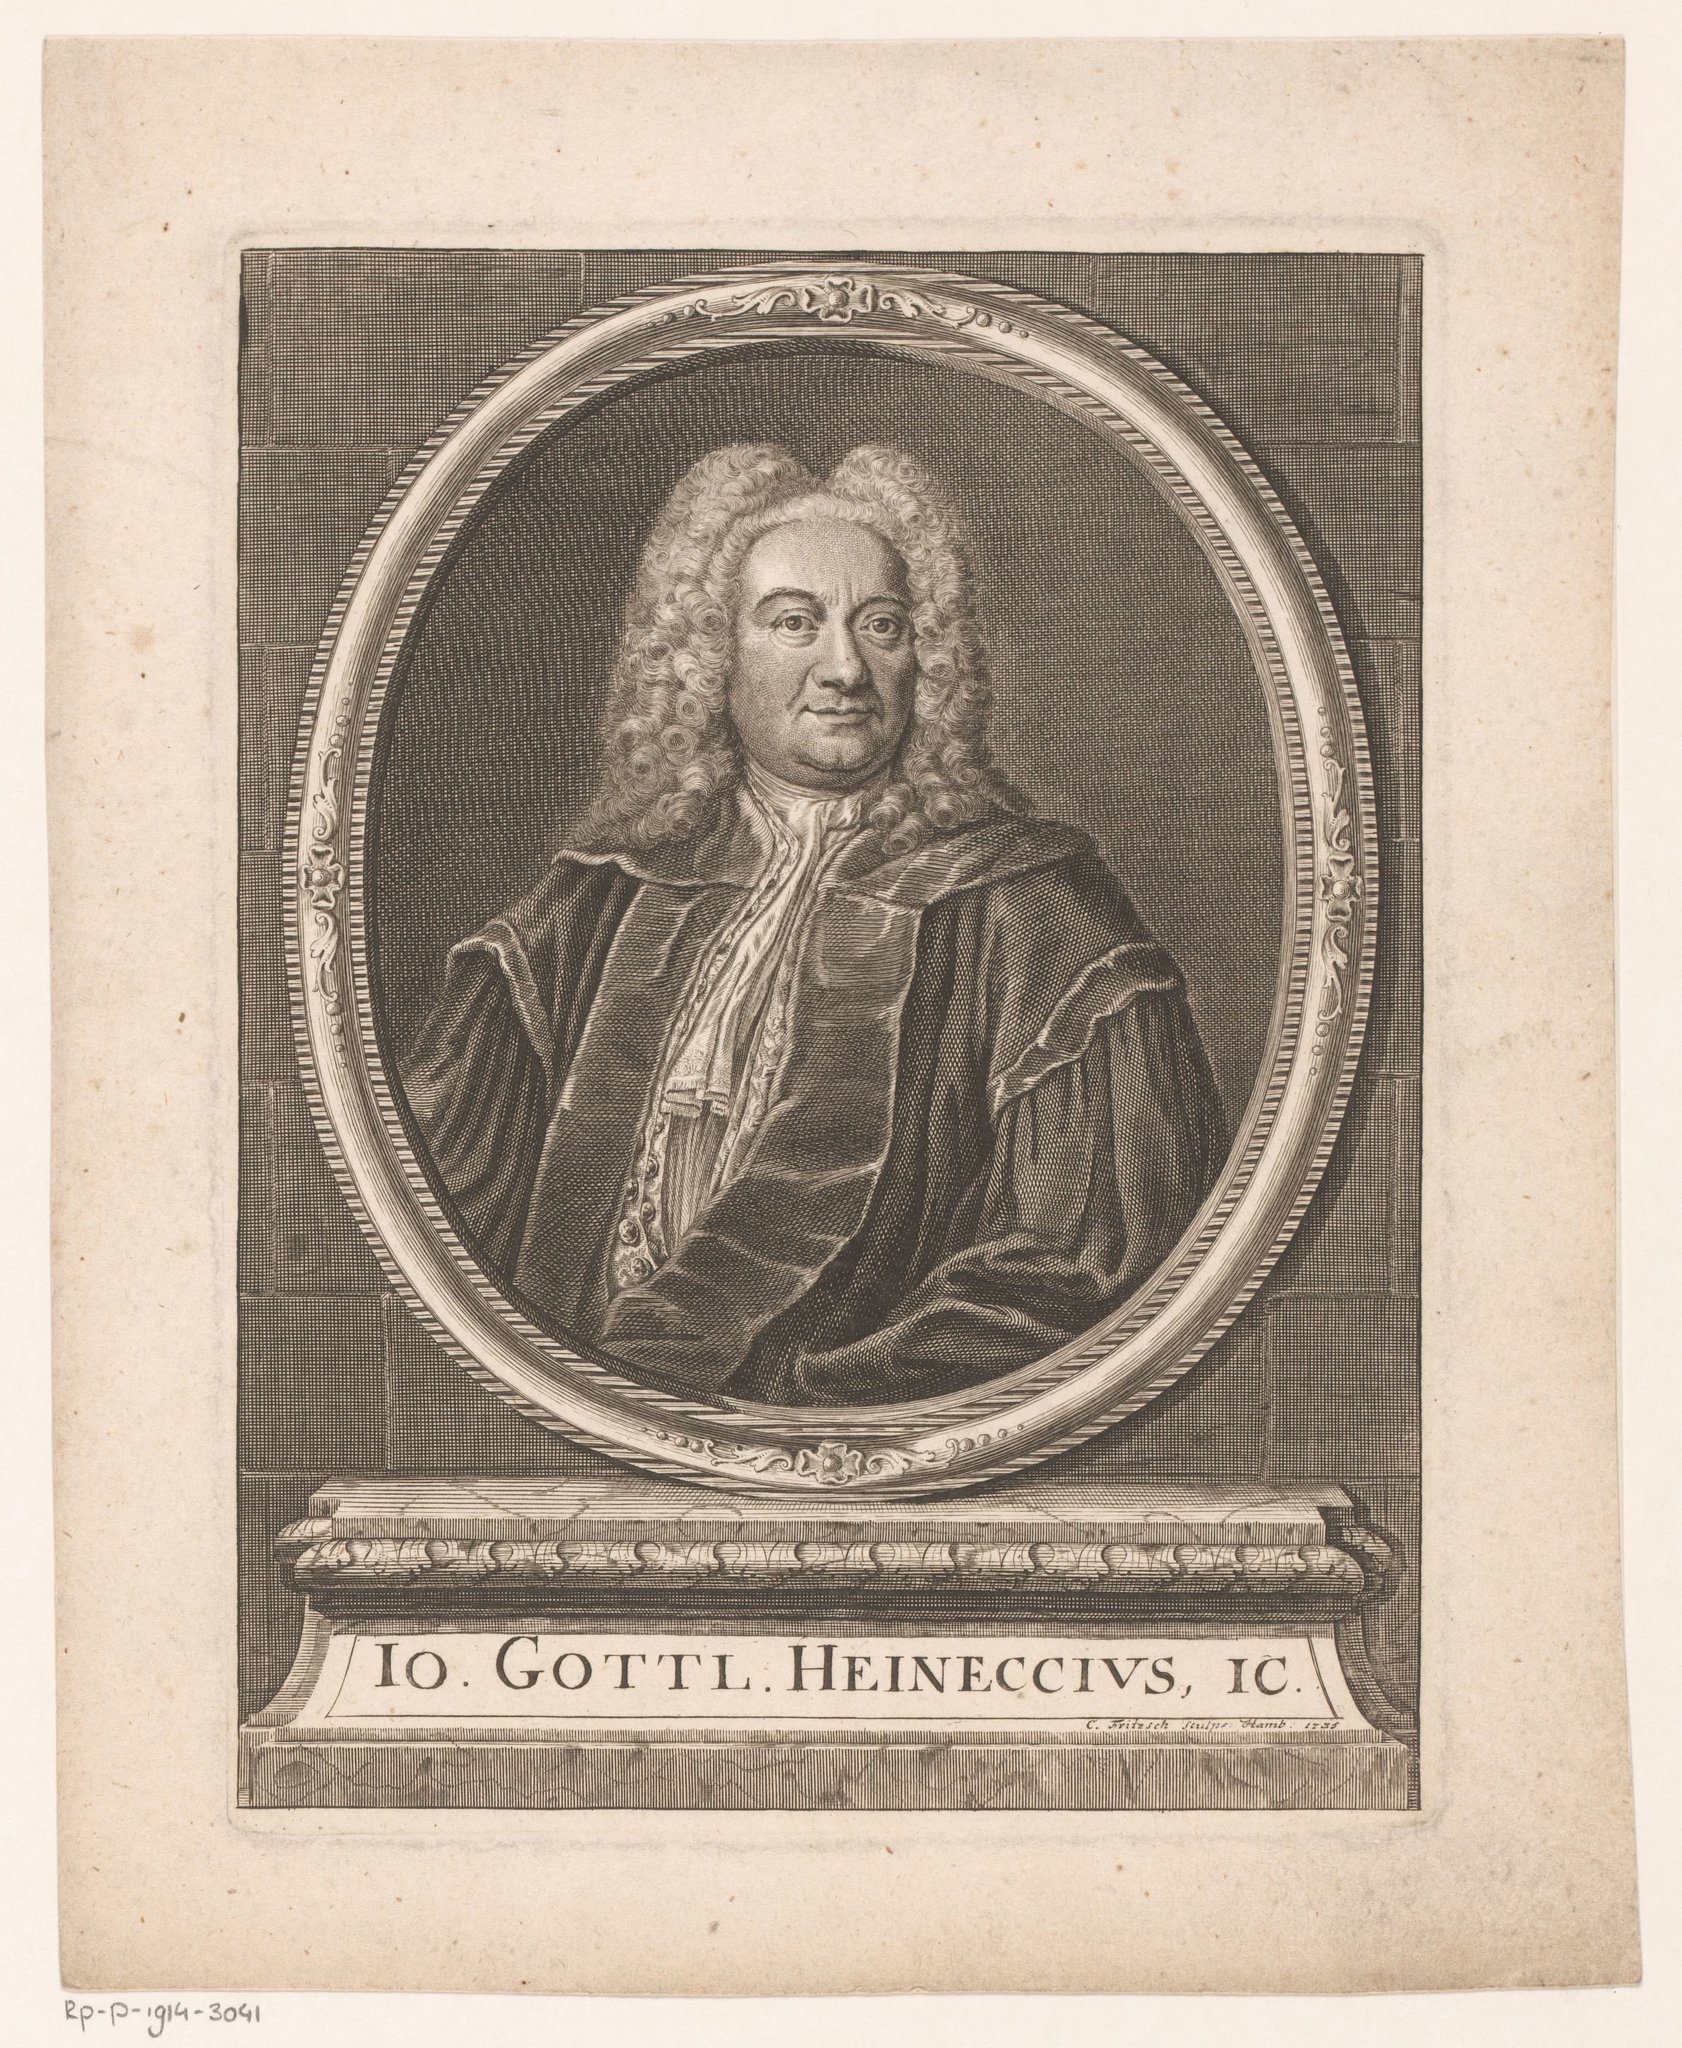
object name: print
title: Portret van Johann Gottlieb Heinecke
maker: christian fritzsch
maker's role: print maker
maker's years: 1695-1769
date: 1735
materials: paper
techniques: engraving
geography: hamburg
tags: ornament ~ medallion, historical persons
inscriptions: collector's mark: Lugt 2228, collector's mark: ‘AG’